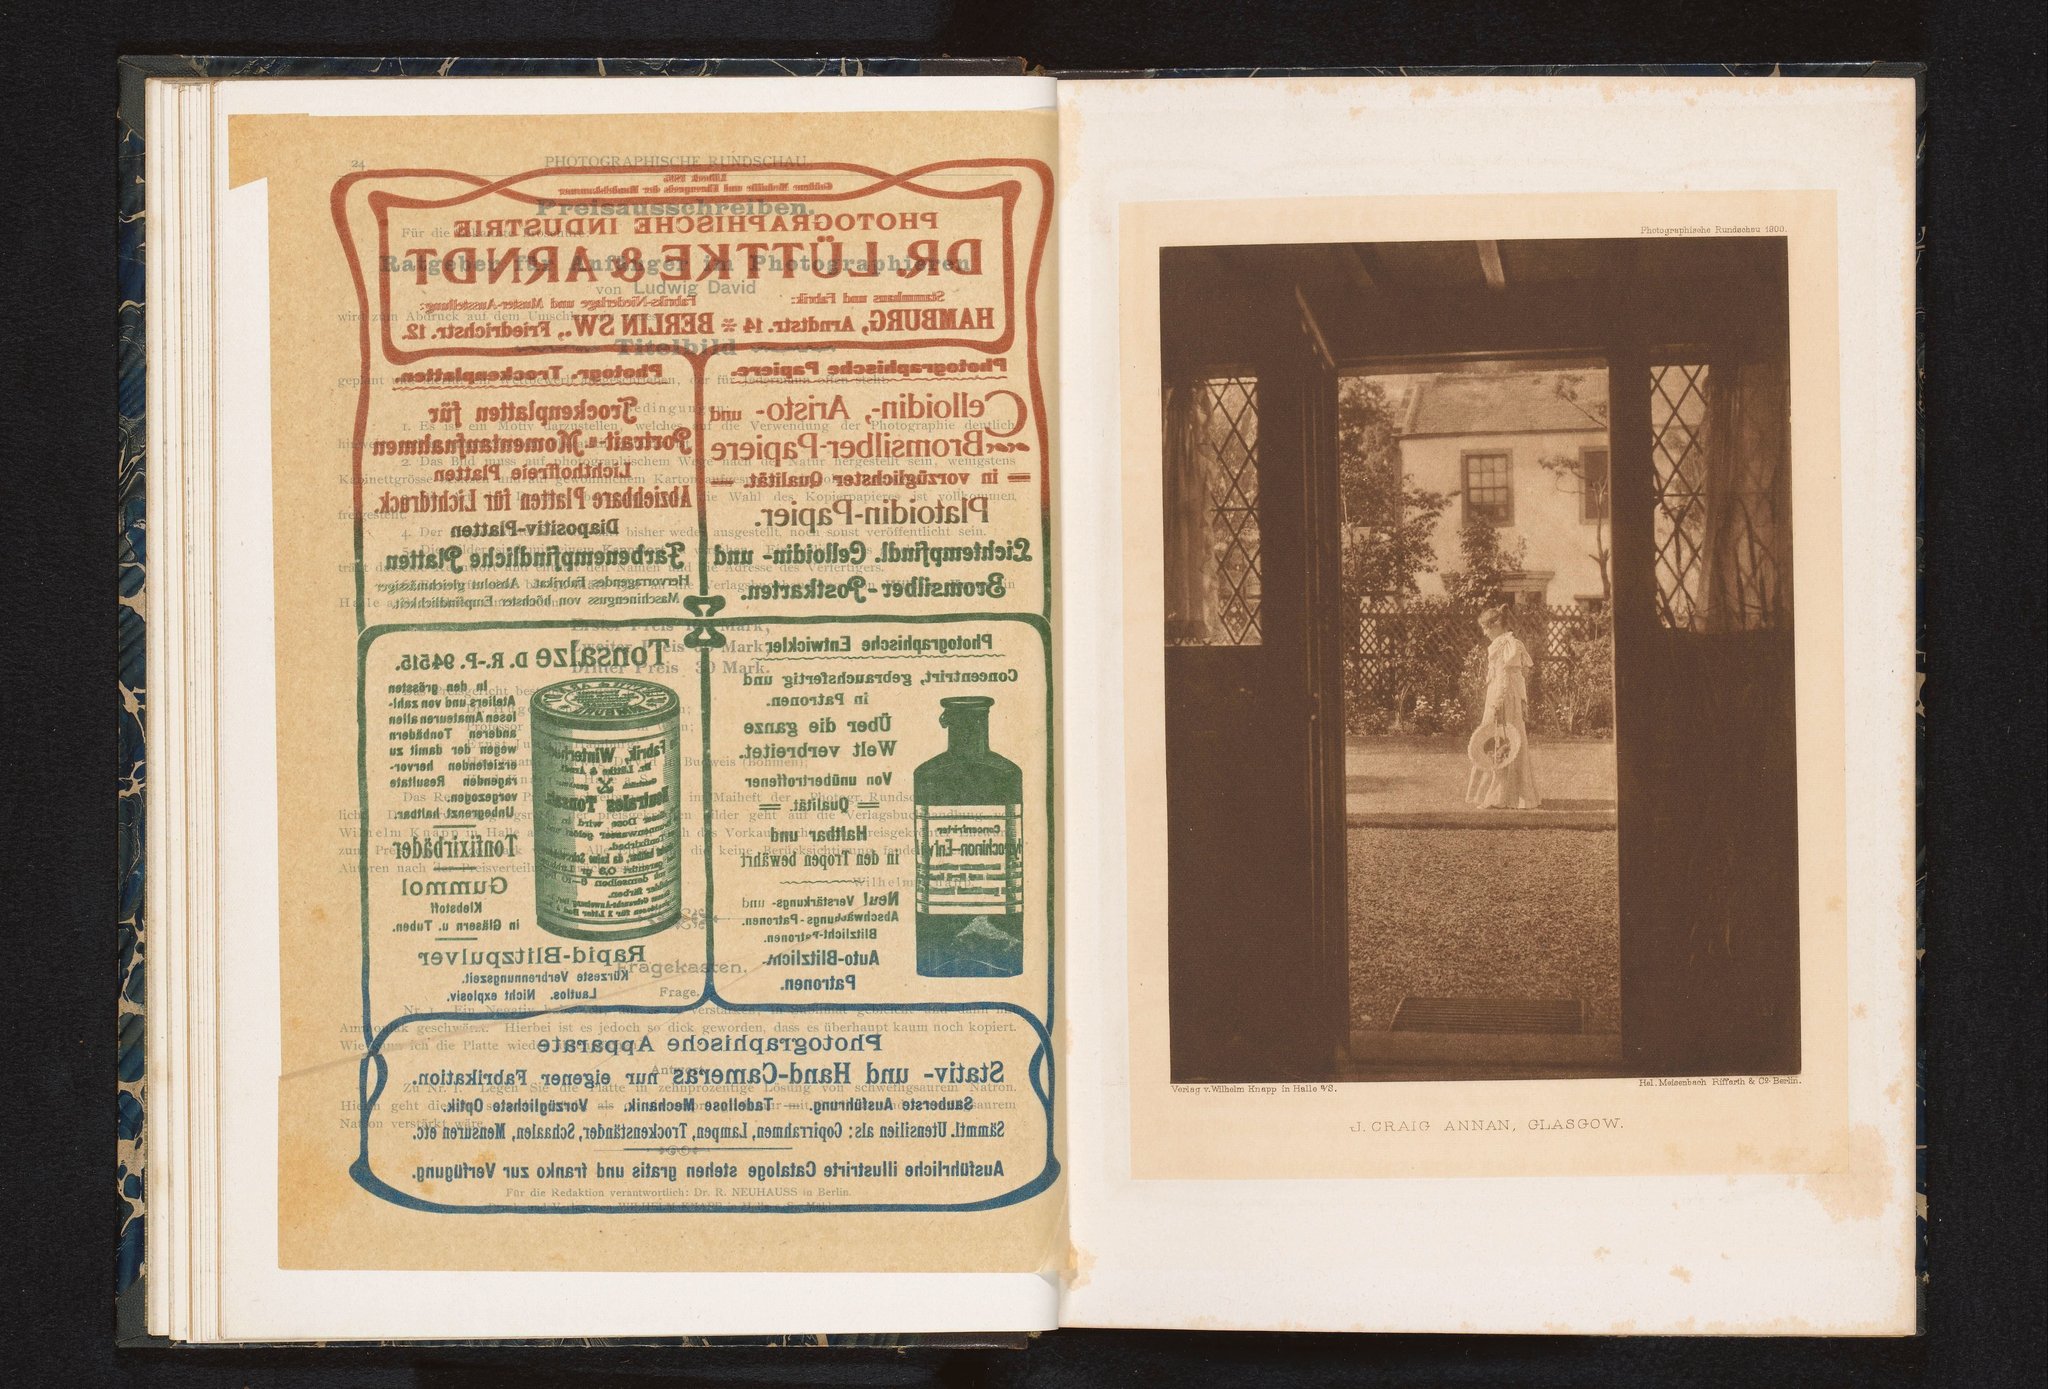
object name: photomechanical print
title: Portret van een onbekende vrouw met een hoed in haar hand, gezien vanuit een gebouw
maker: james craig annan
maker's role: fotograaf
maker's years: 1864-1946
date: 1896-1901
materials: paper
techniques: photoaquatint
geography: berlin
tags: historical persons not known by name - bb - woman, door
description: Prent tegenover pagina 24, achter semi-transparante omslag met reclameboodschap.